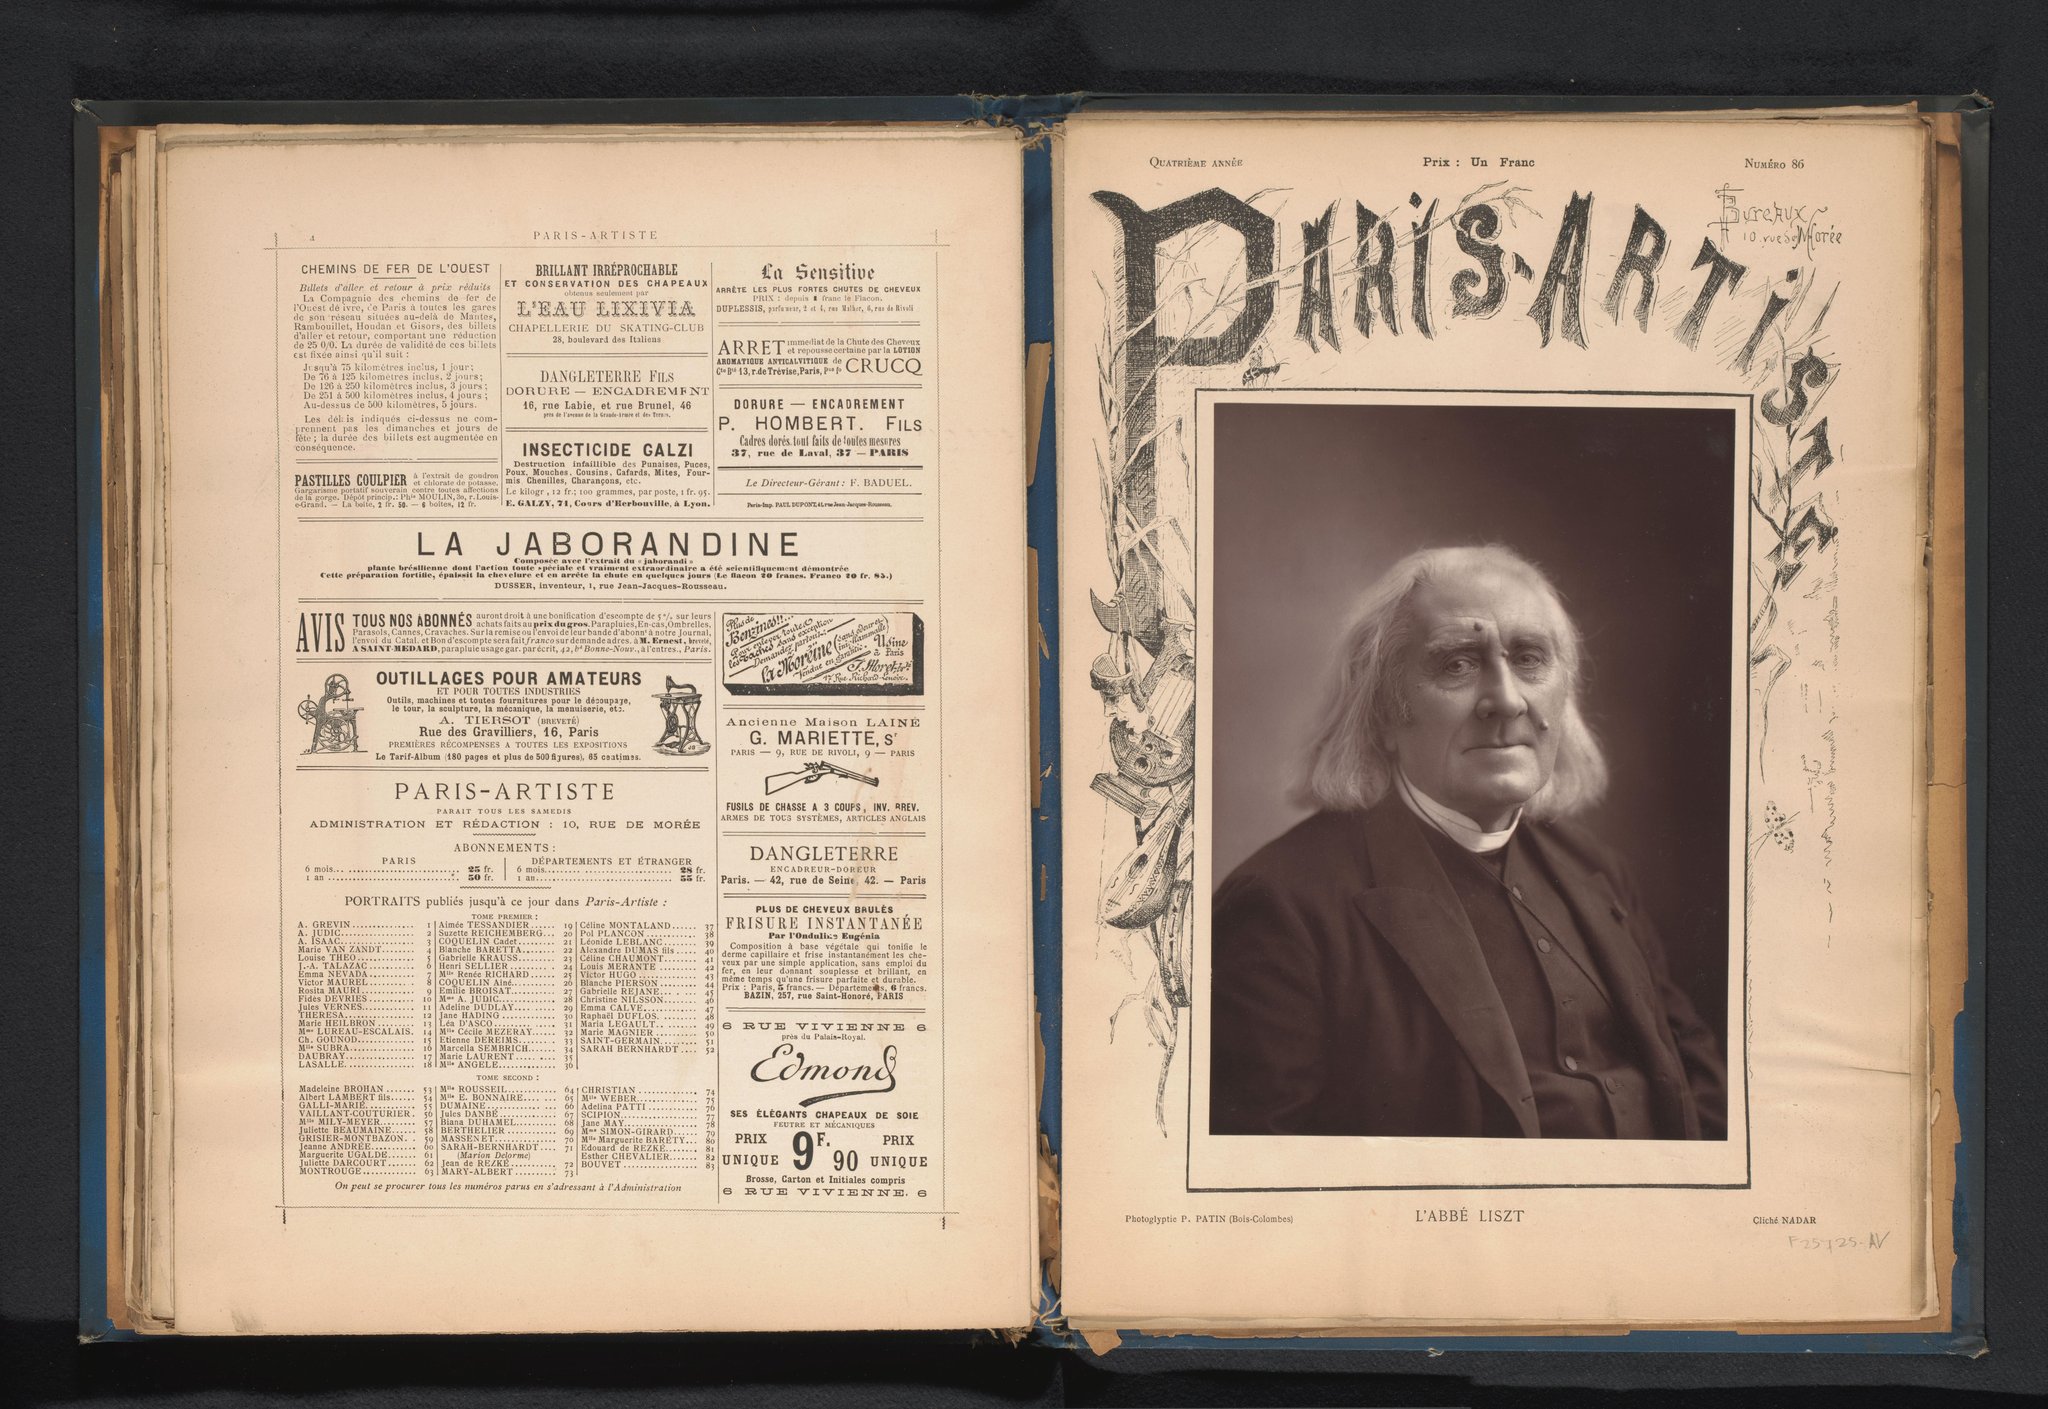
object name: photomechanical print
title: Portret van Franz Liszt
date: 1875-1886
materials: paper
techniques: woodburytype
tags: historical persons, composer